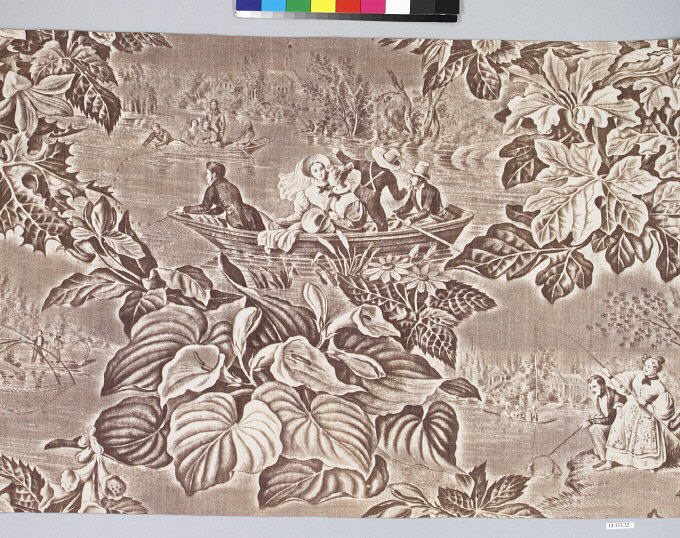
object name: furnishing textile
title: Pictorial print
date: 1830-1840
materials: cotton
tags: men,women,fishing,leaves,boats